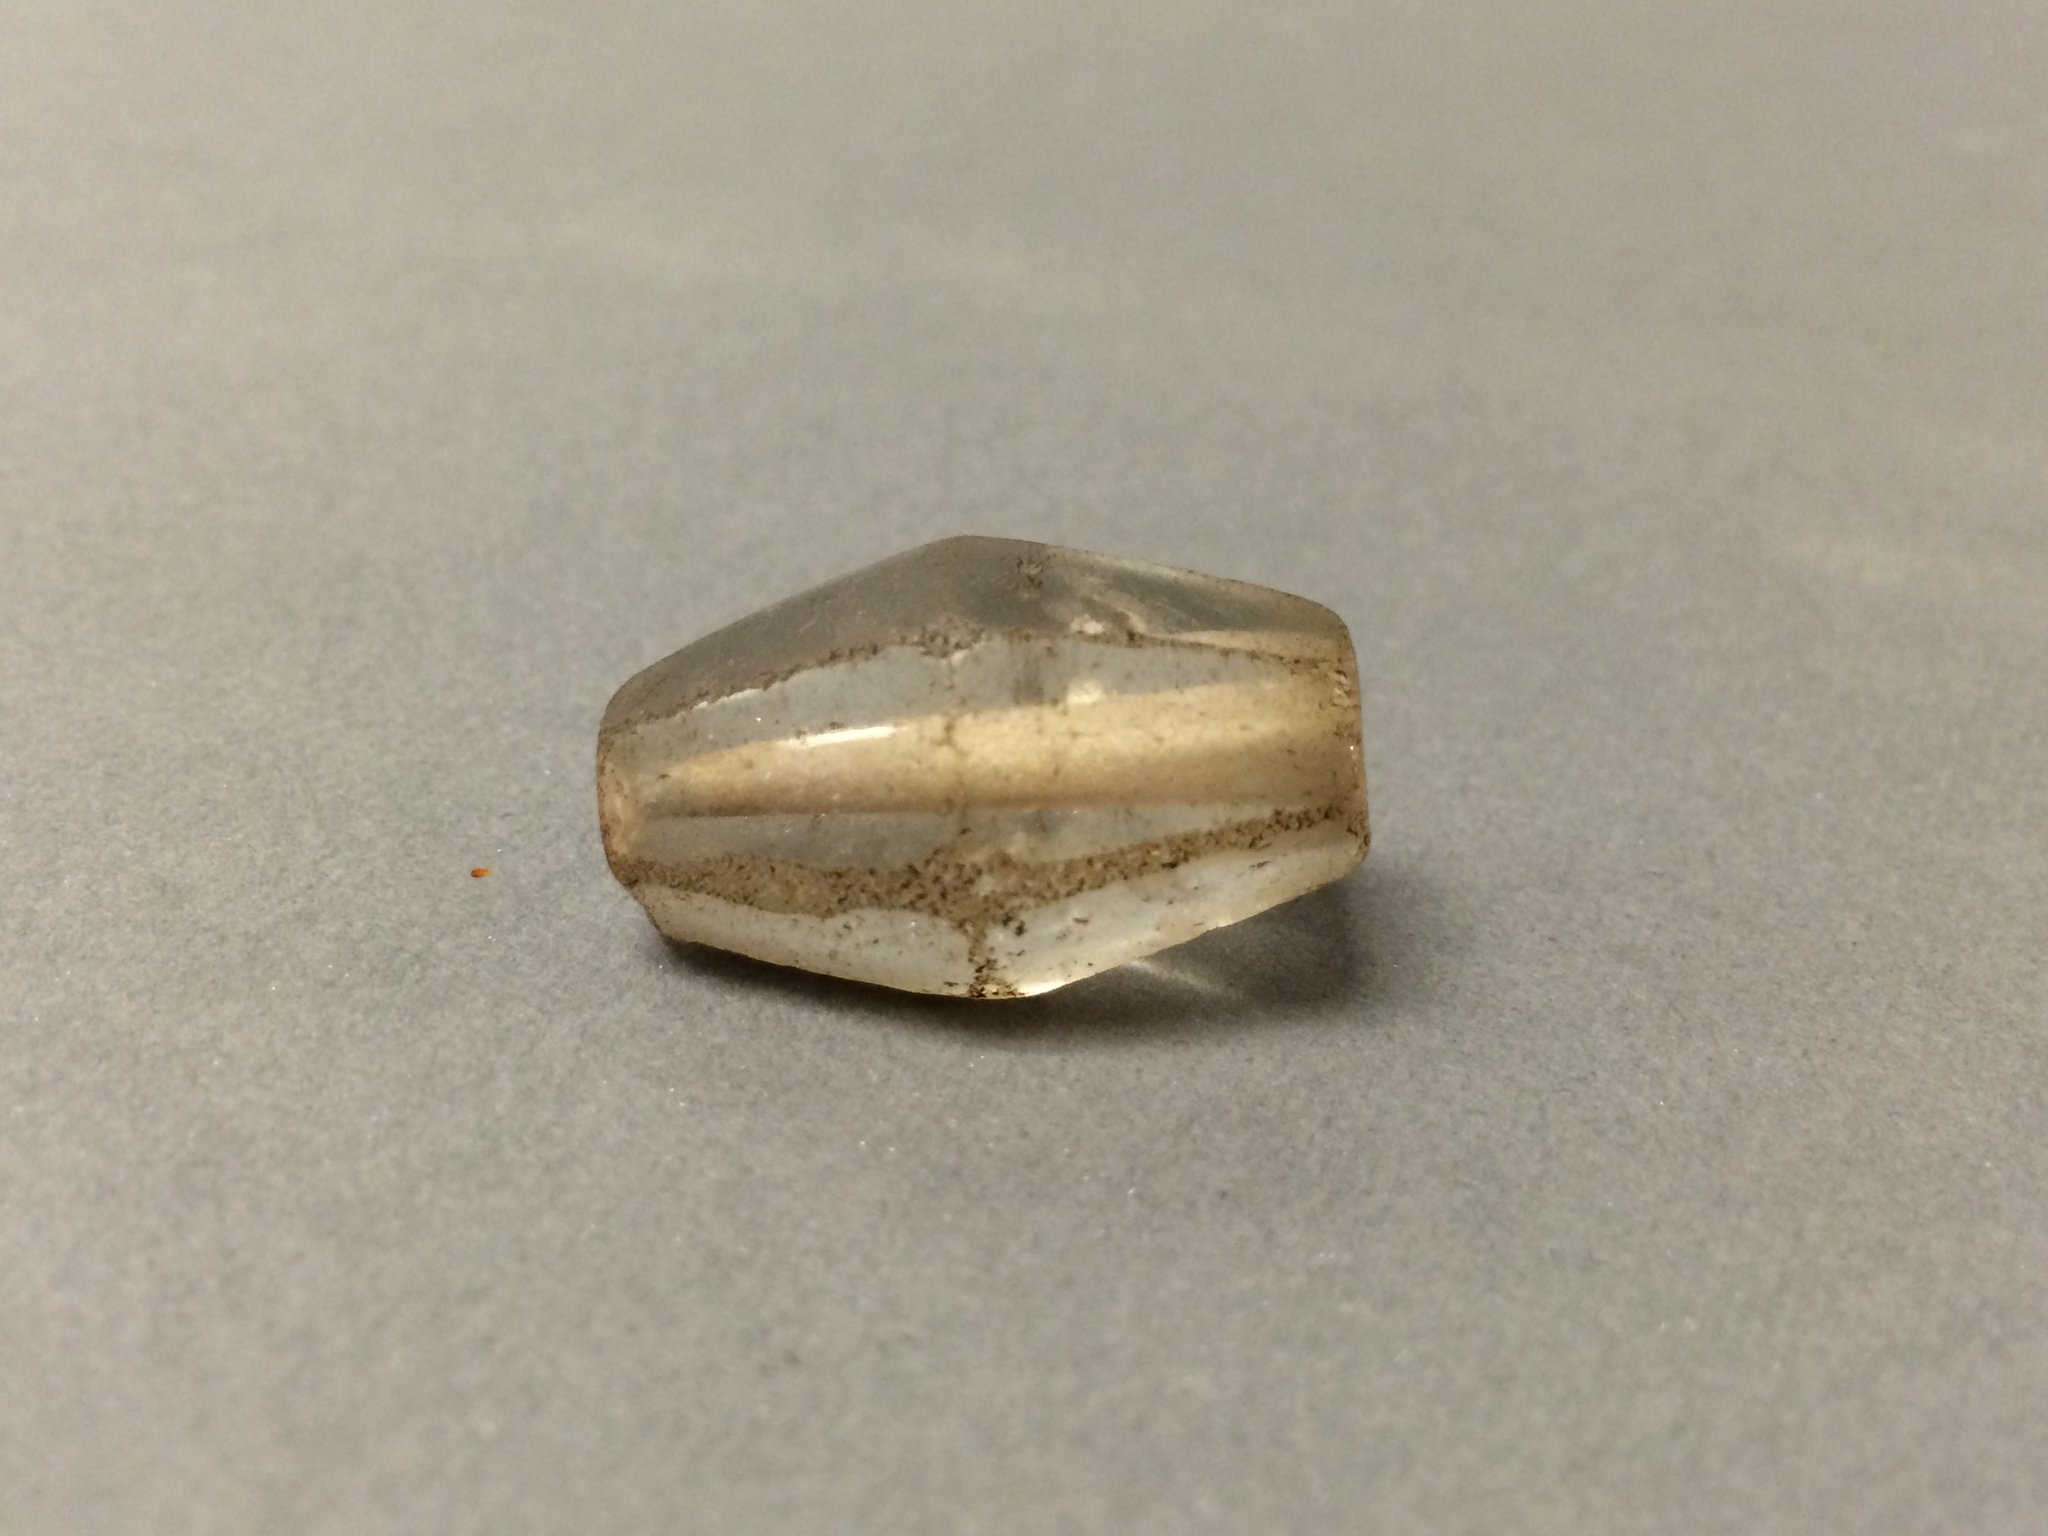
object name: bead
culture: japanese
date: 601-700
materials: crystal